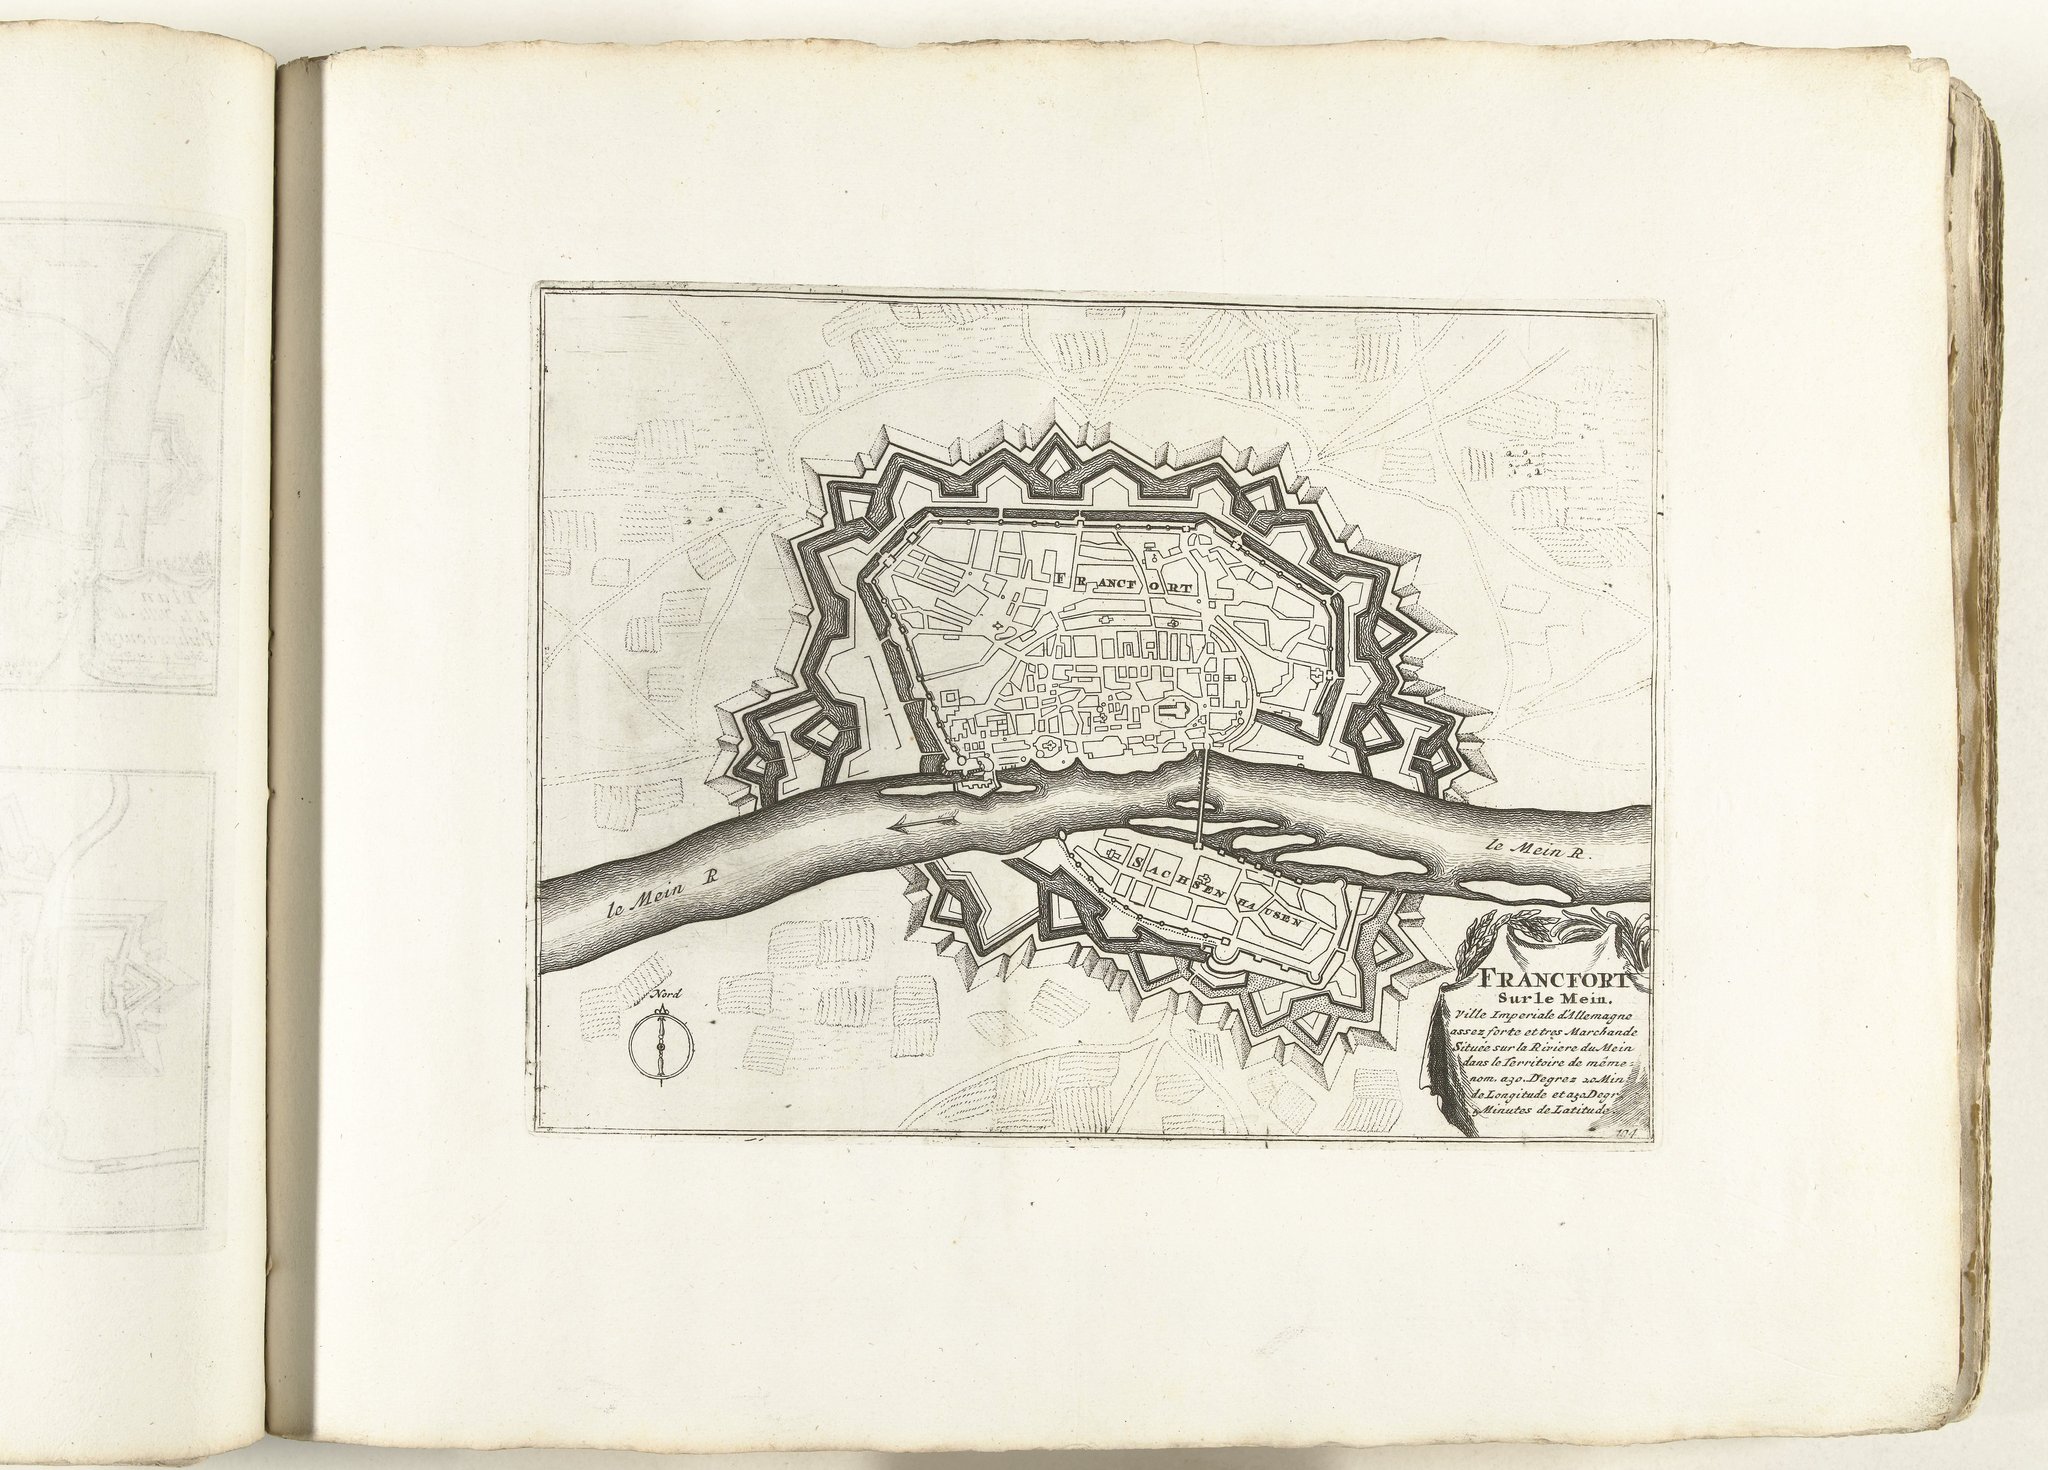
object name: print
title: Francfort Sur le mein. Ville Imperiale d'Allemagne (...)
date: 1702-1703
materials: paper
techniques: etching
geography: northern netherlands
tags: fortress, maps of cities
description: Plattegrond van de versterkingen om de plaats Frankfurt am Main. Plaat nr. 104 in het prentwerk bestaande in totaal uit 276 genummerde platen van vermaarde sterke steden en vestingen in het kader van de Spaanse Successieoorlog. Voor het merendeel zijn deze platen gekopieerd naar de anonieme Franse platen: in Les forces de l'Europe en in: Le theatre de la guerre, dans les Pays-Bas, beide oorspronkelijk uitgegeven door Nicolas de Fer te Parijs (1693-1697) in het kader van de Negenjarige Oorlog. Titel en opschriften in de plaat in het Frans.